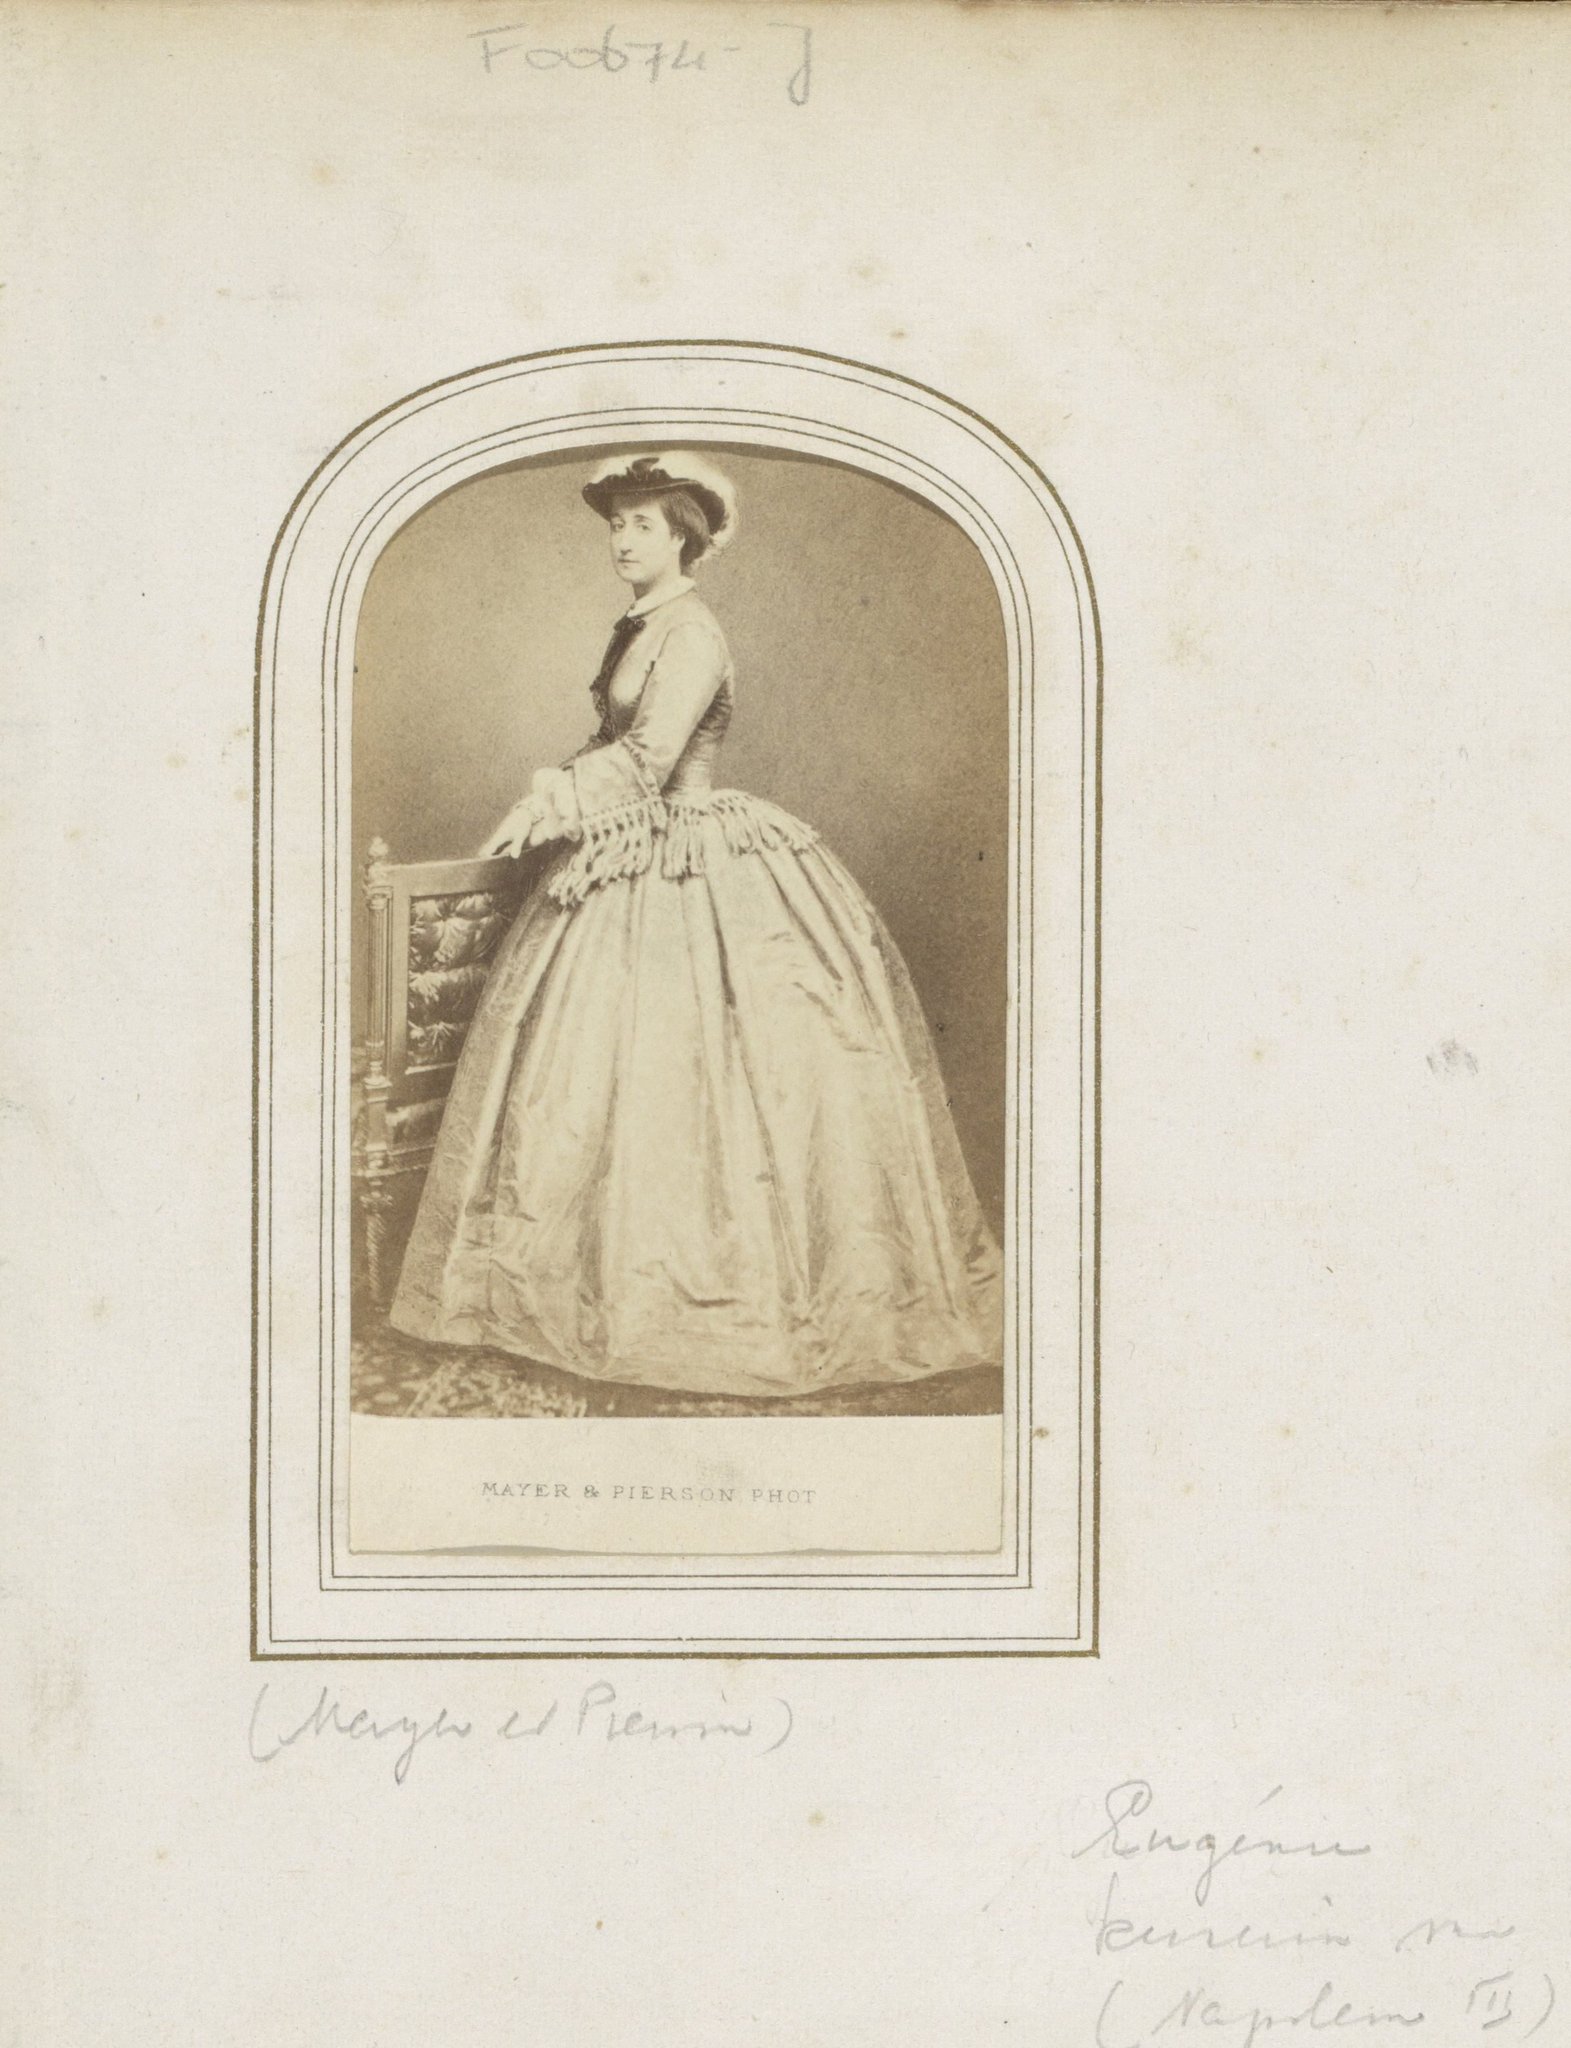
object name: carte de visite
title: Portret van Eugénie, keizerin van Frankrijk, echtgenote Napoleon III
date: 1855-1865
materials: cardboard, paper, photographic support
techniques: albumen print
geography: paris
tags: sevilla, studio requisites ~ photographer, head-gear, historical persons, clothing for the upper part of the body, skirt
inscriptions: address: ‘Paris, Boulevart des Capucines 3’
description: Onderdeel van Fotoalbum met 123 cartes-de-visite van leden van Europese vorstenhuizen, politici en bekende personen.